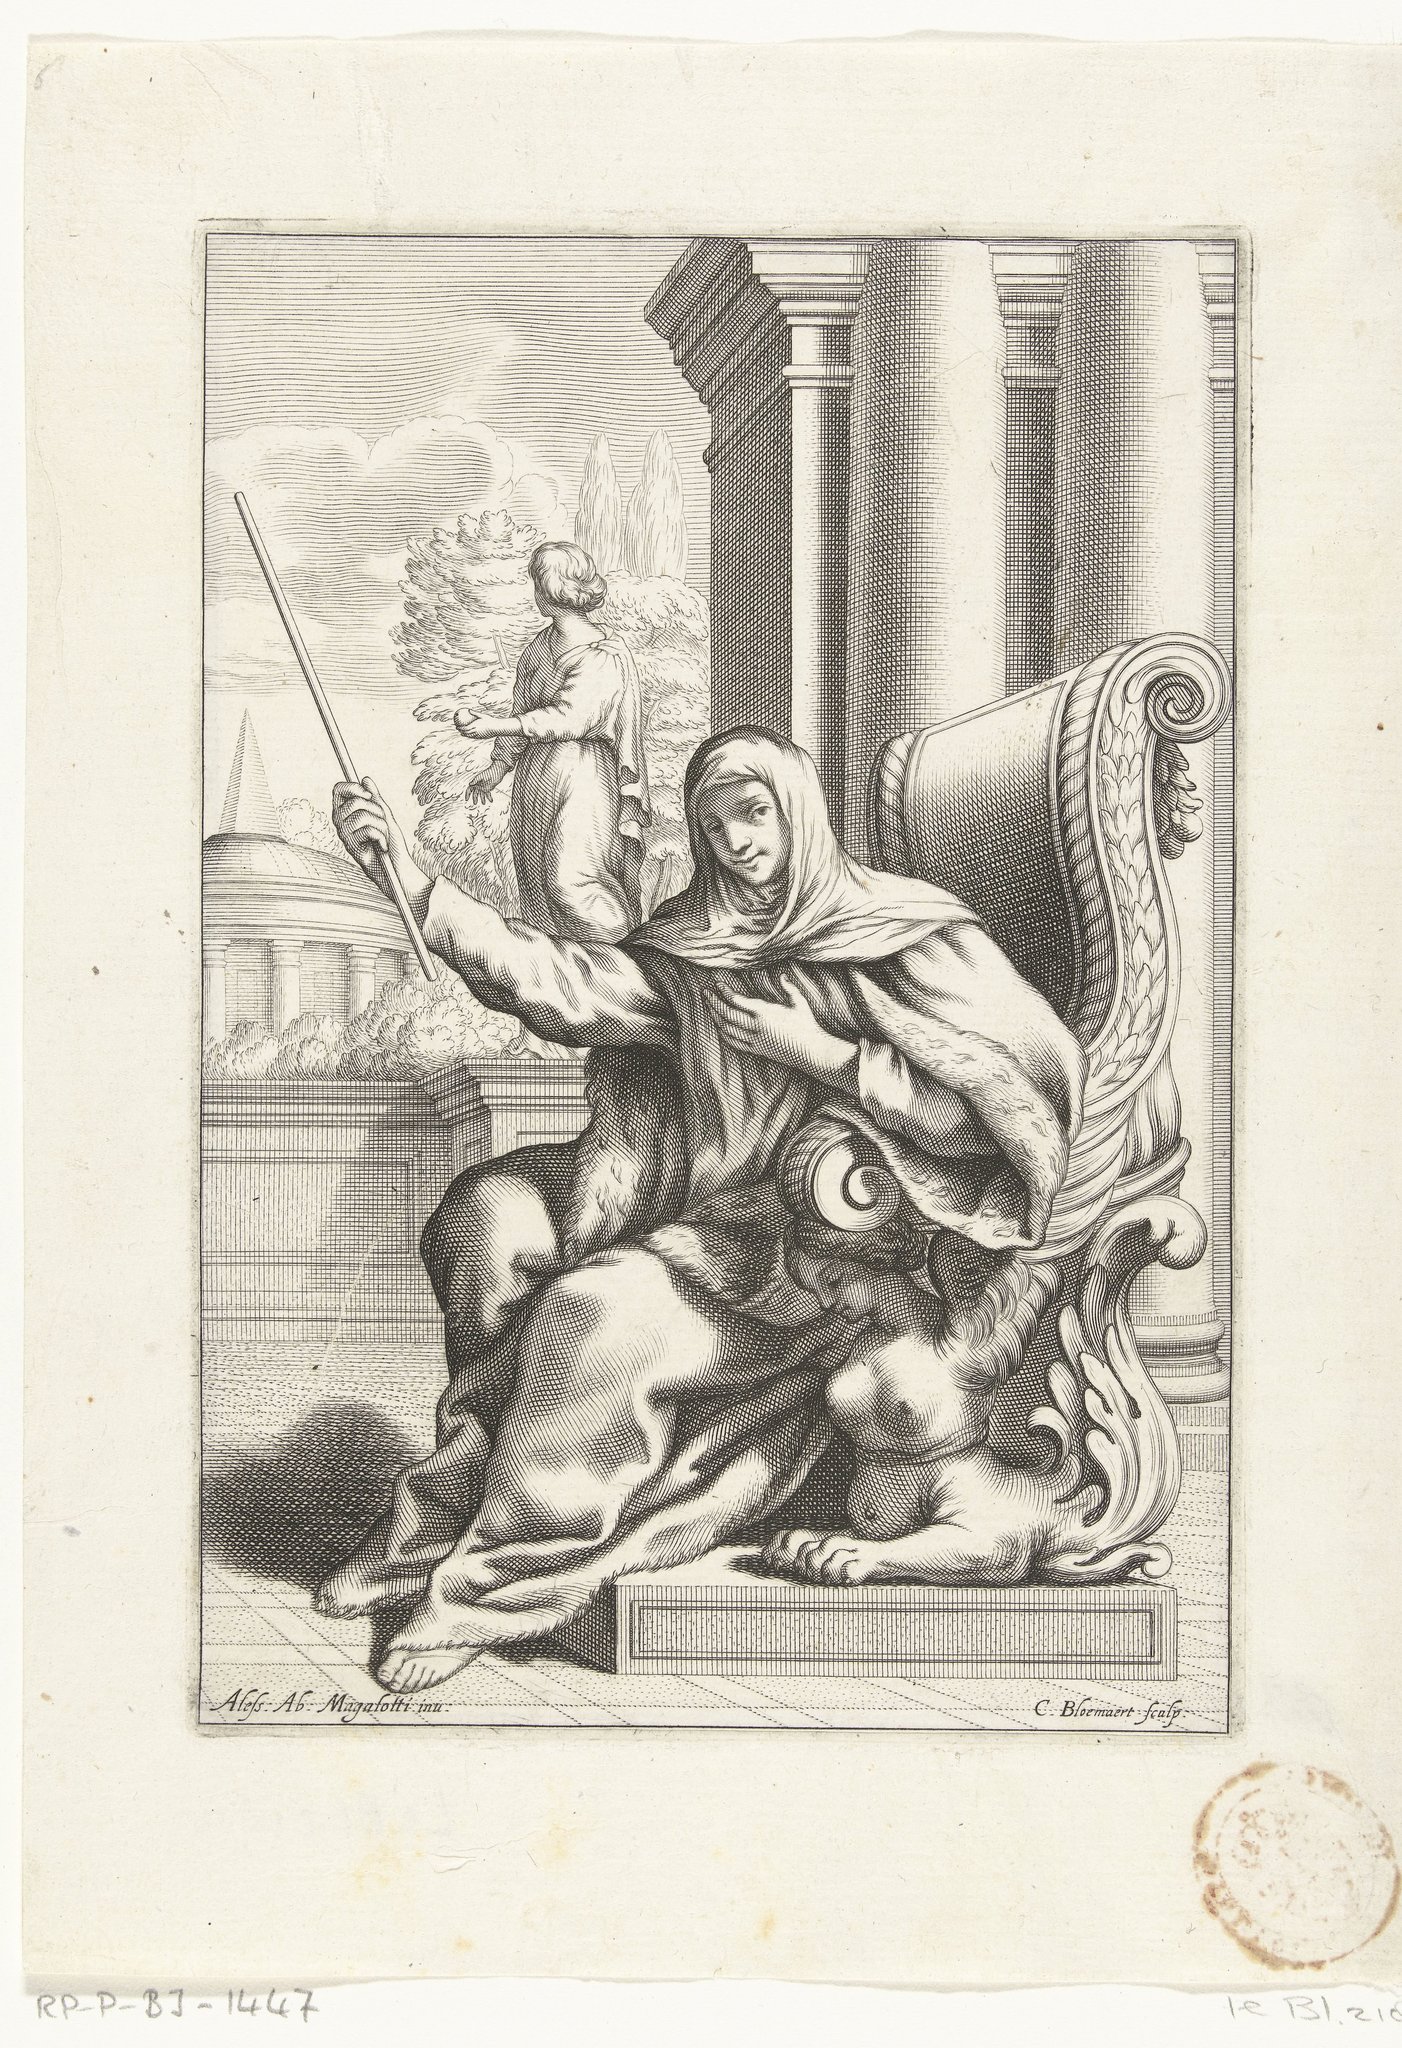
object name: print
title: Docilita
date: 1640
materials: paper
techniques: engraving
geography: rome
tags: throne, docility; 'docilità' (ripa)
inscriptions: collector's mark: Lugt 240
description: Een vrouw zit op een troon en wijst met een stok in haar rechterhand naar boven. De vrouw draagt een hermelijnen mantel en een doek over haar hoofd. Illustratie voor het hoofdstuk Sotto Docilitate uit het boek Documenti d'Amore.